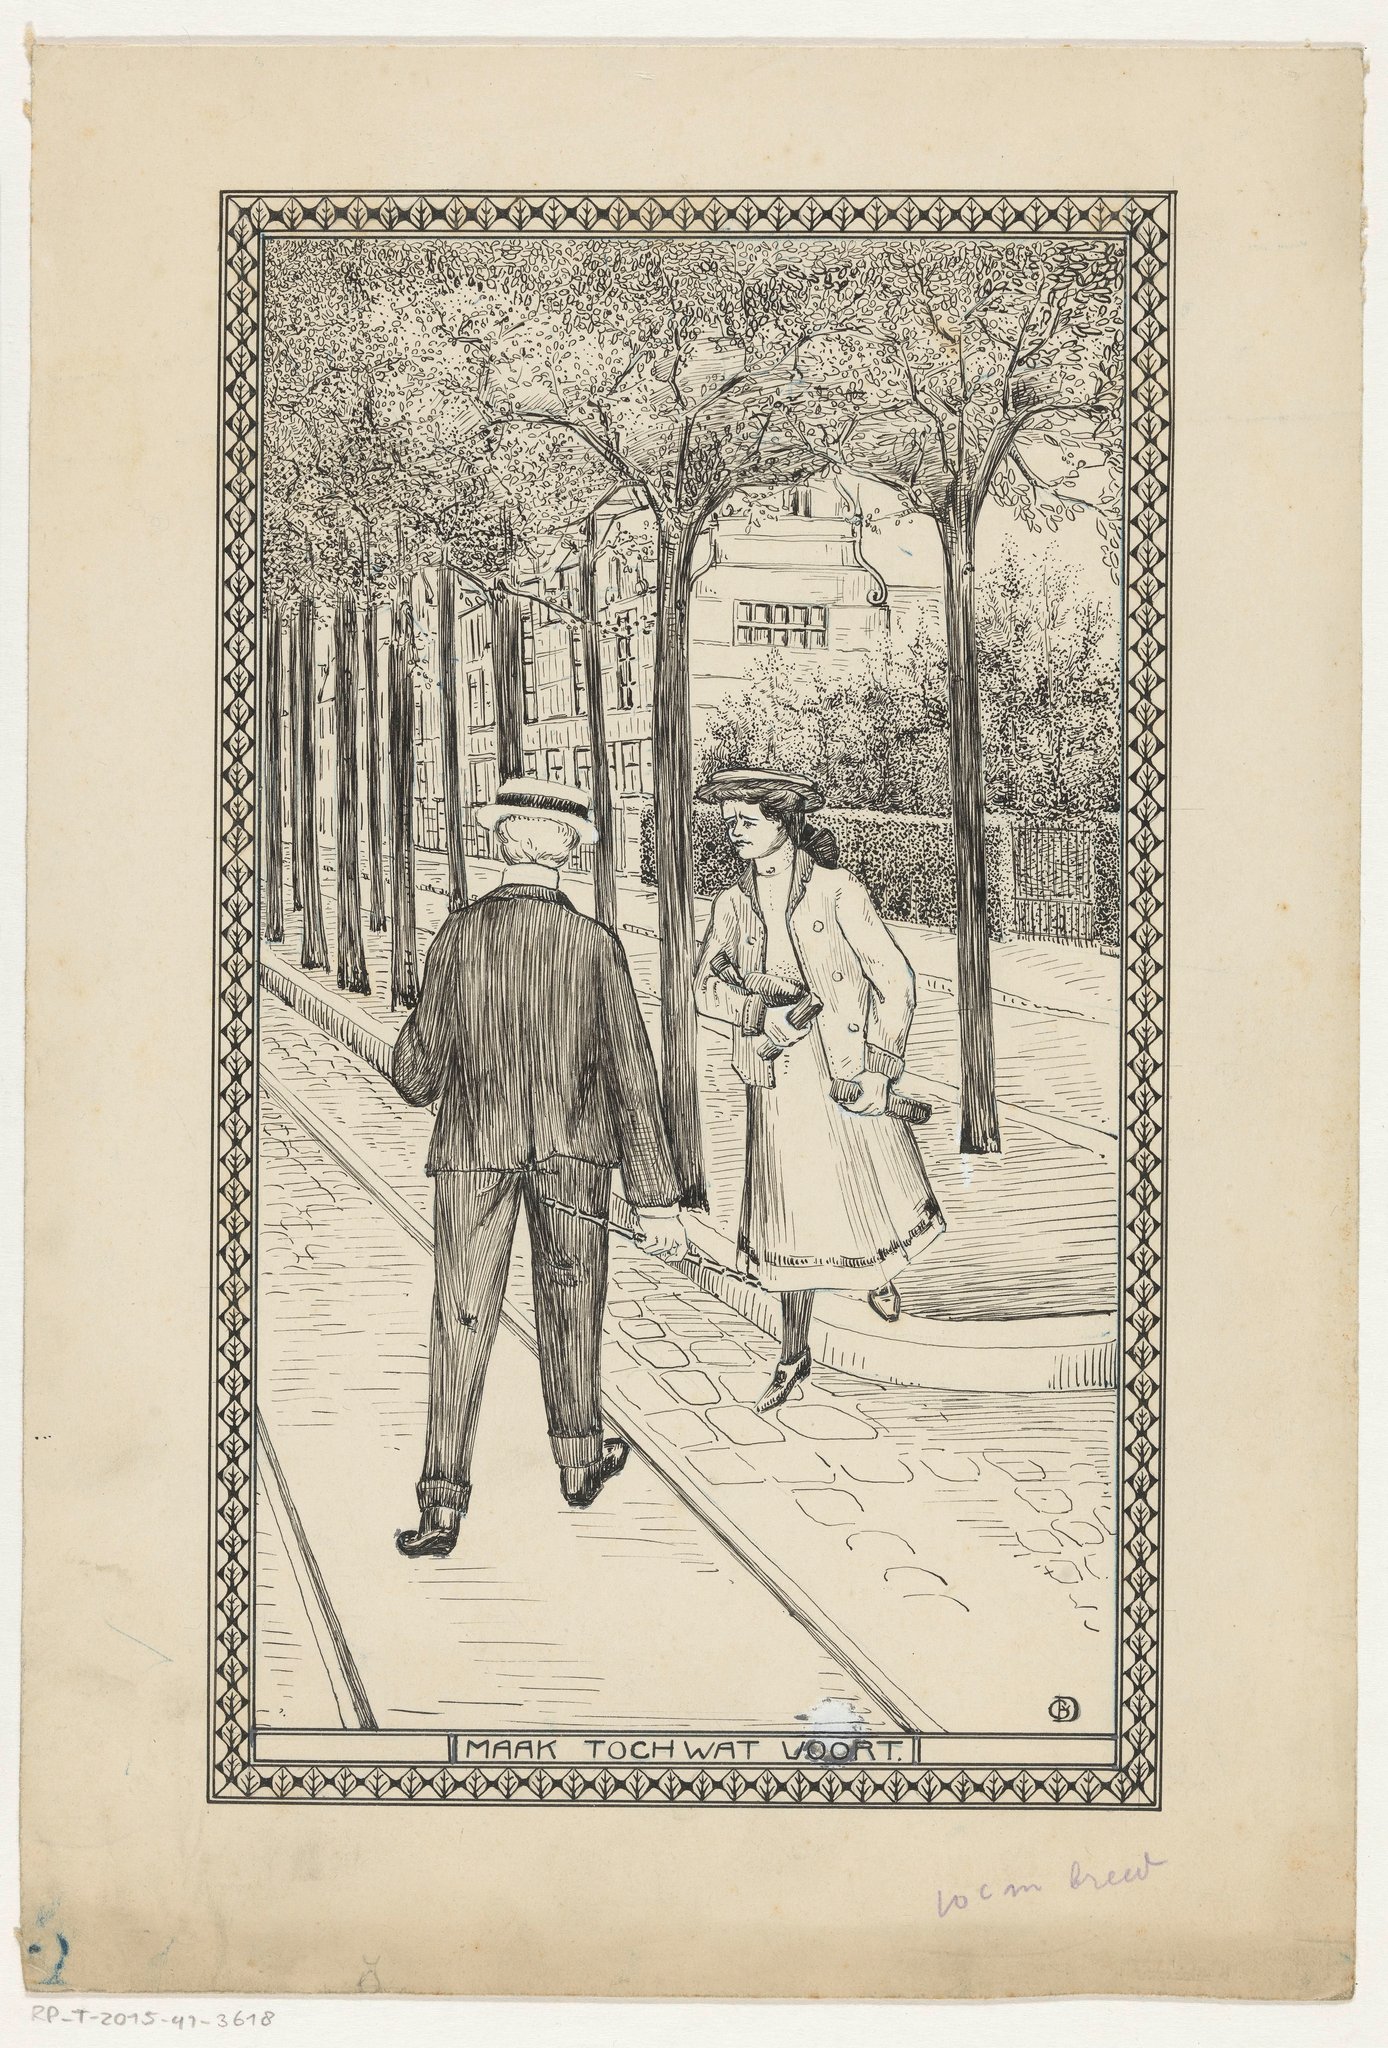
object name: boekillustratie ontwerp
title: MAAK TOCH WAT VOORT.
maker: g. van doorn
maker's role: illustrator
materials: paint, ink, paper, pencil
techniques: brush, pen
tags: quarrel, argument, street (+ city(-scape) with figures, staffage), the hague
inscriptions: monogram: ‘GvD’, :, collector's mark: Lugt 2228a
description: Frida en Hein ontmoeten elkaar op de Haagse Laan van Meerdervoort. Frida kijkt nijdig naar Hein. Ze draagt een aantal pakketten in haar armen.